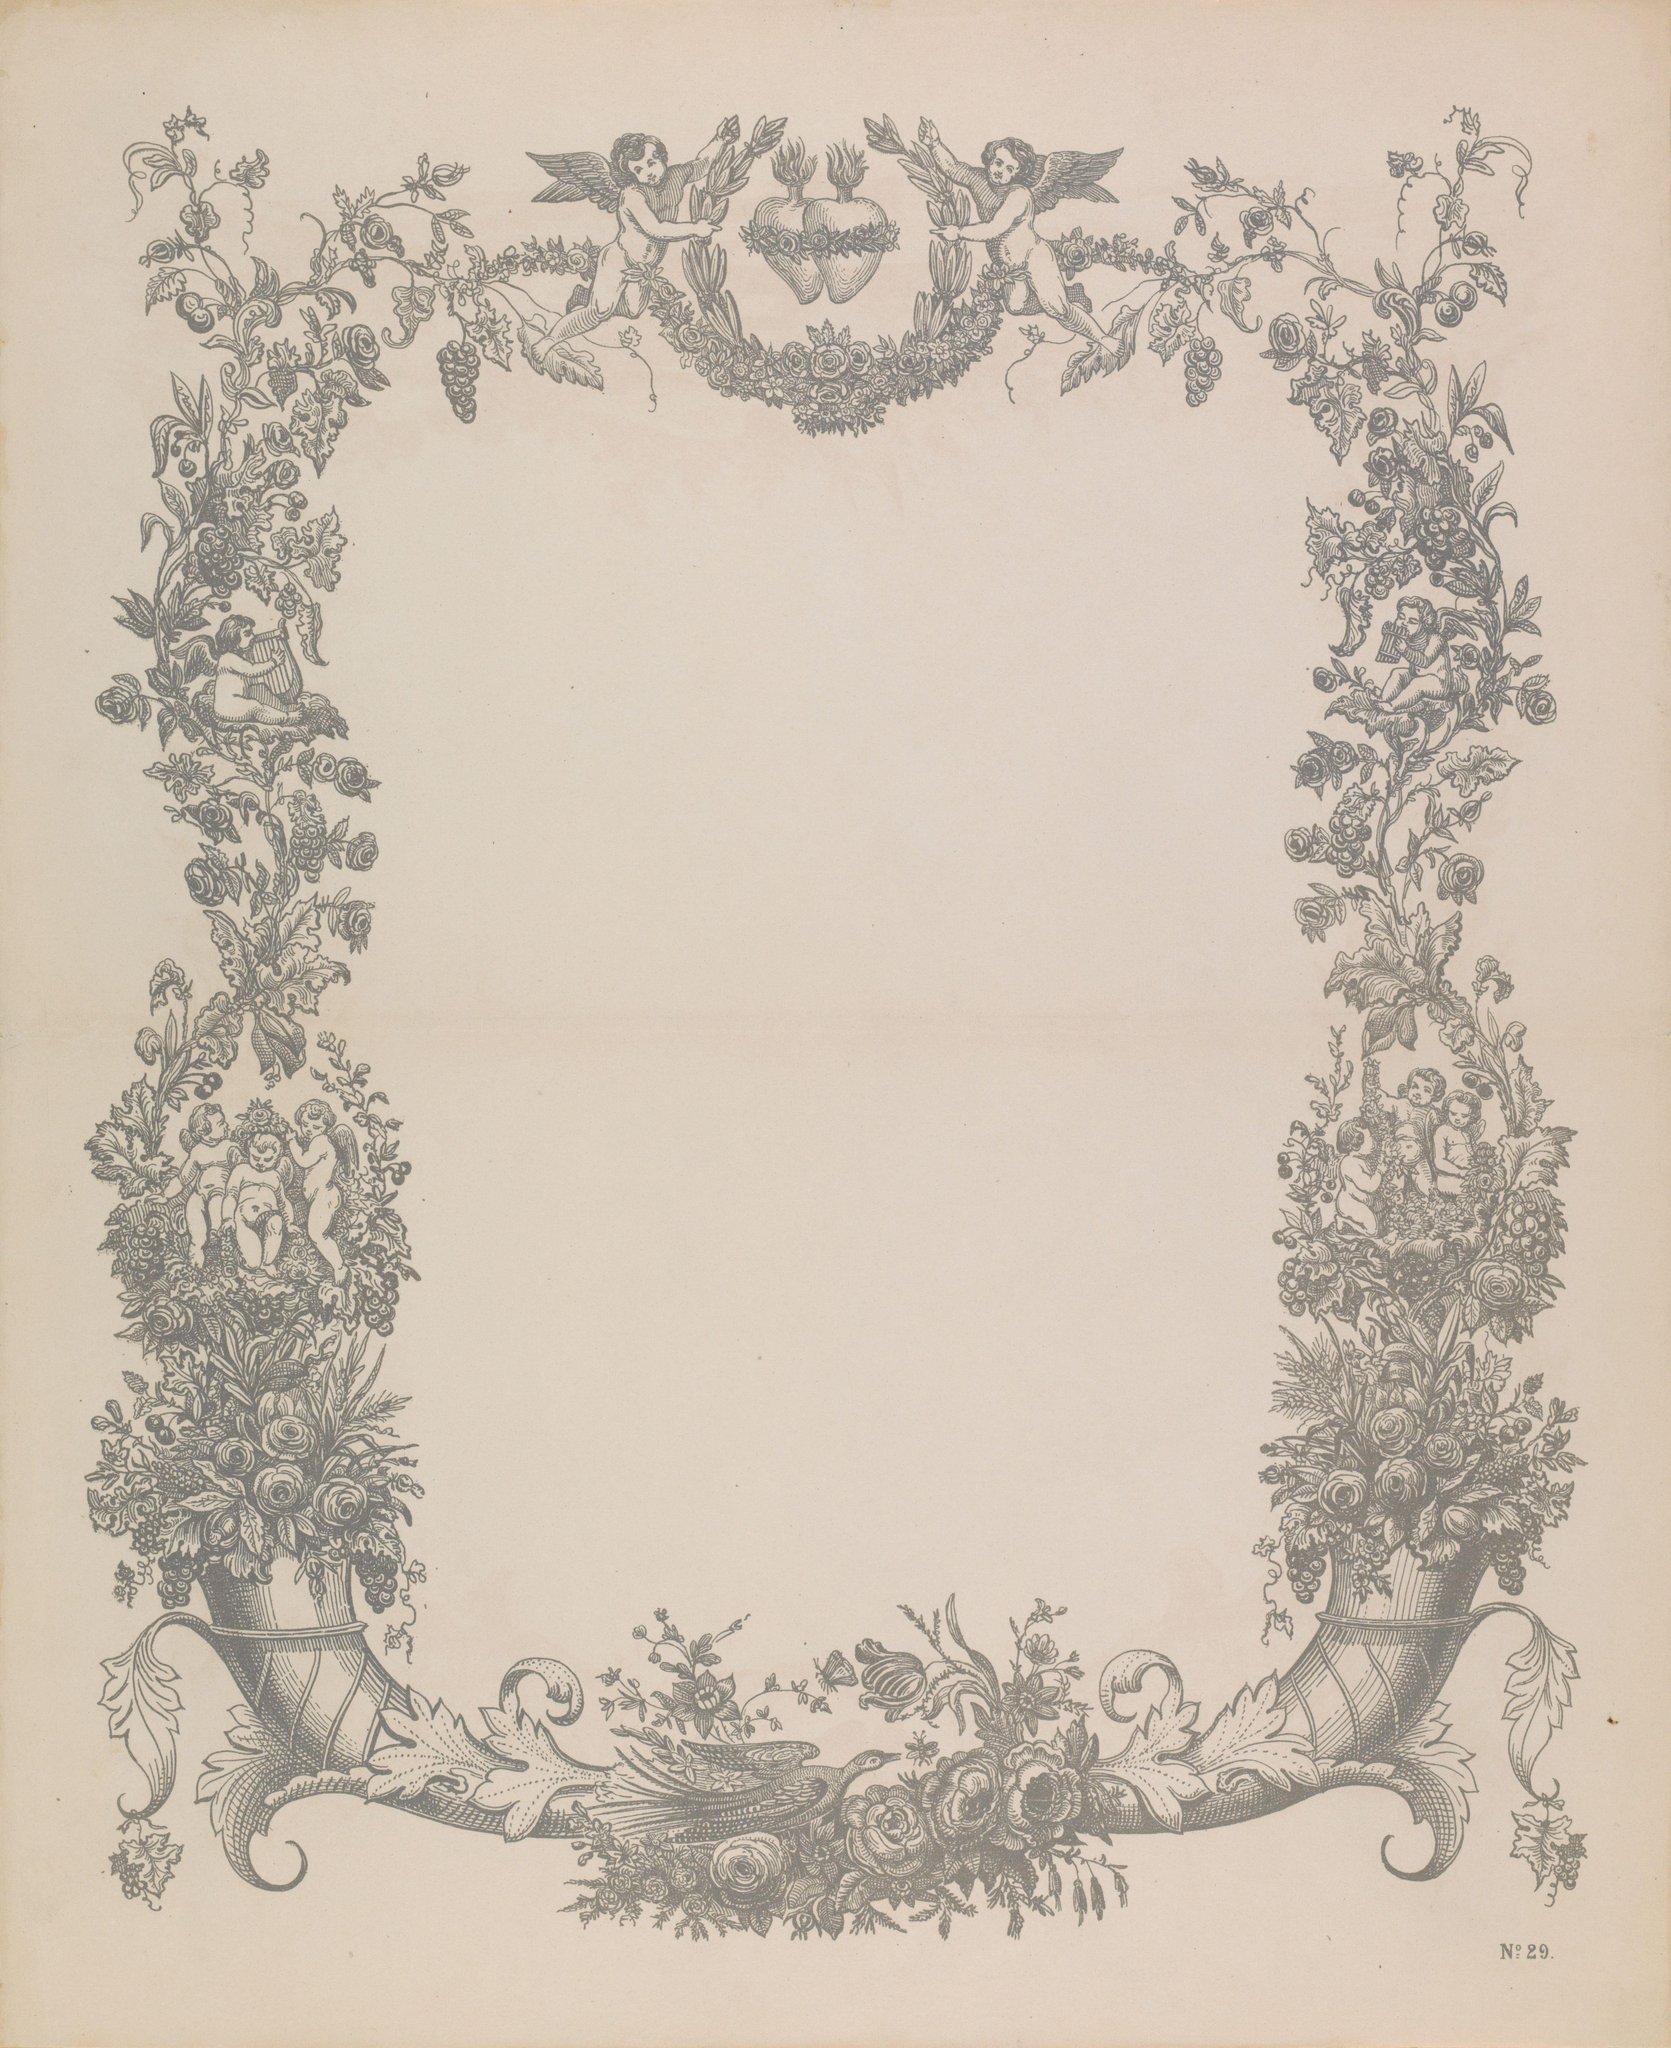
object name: wensbrief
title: Wensbrief met bloemen en putti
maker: Anonymous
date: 1780-1899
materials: paper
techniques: lithograph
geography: netherlands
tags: flowers, flowers: rose, cupids: 'amores', 'amoretti', 'putti'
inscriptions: collector's mark: Lugt 2760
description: Wensbrief met onbeschreven cartouche binnen een decoratief kader met voorstellingen van bloemen en putti. Genummerd rechtsonder: No. 29.